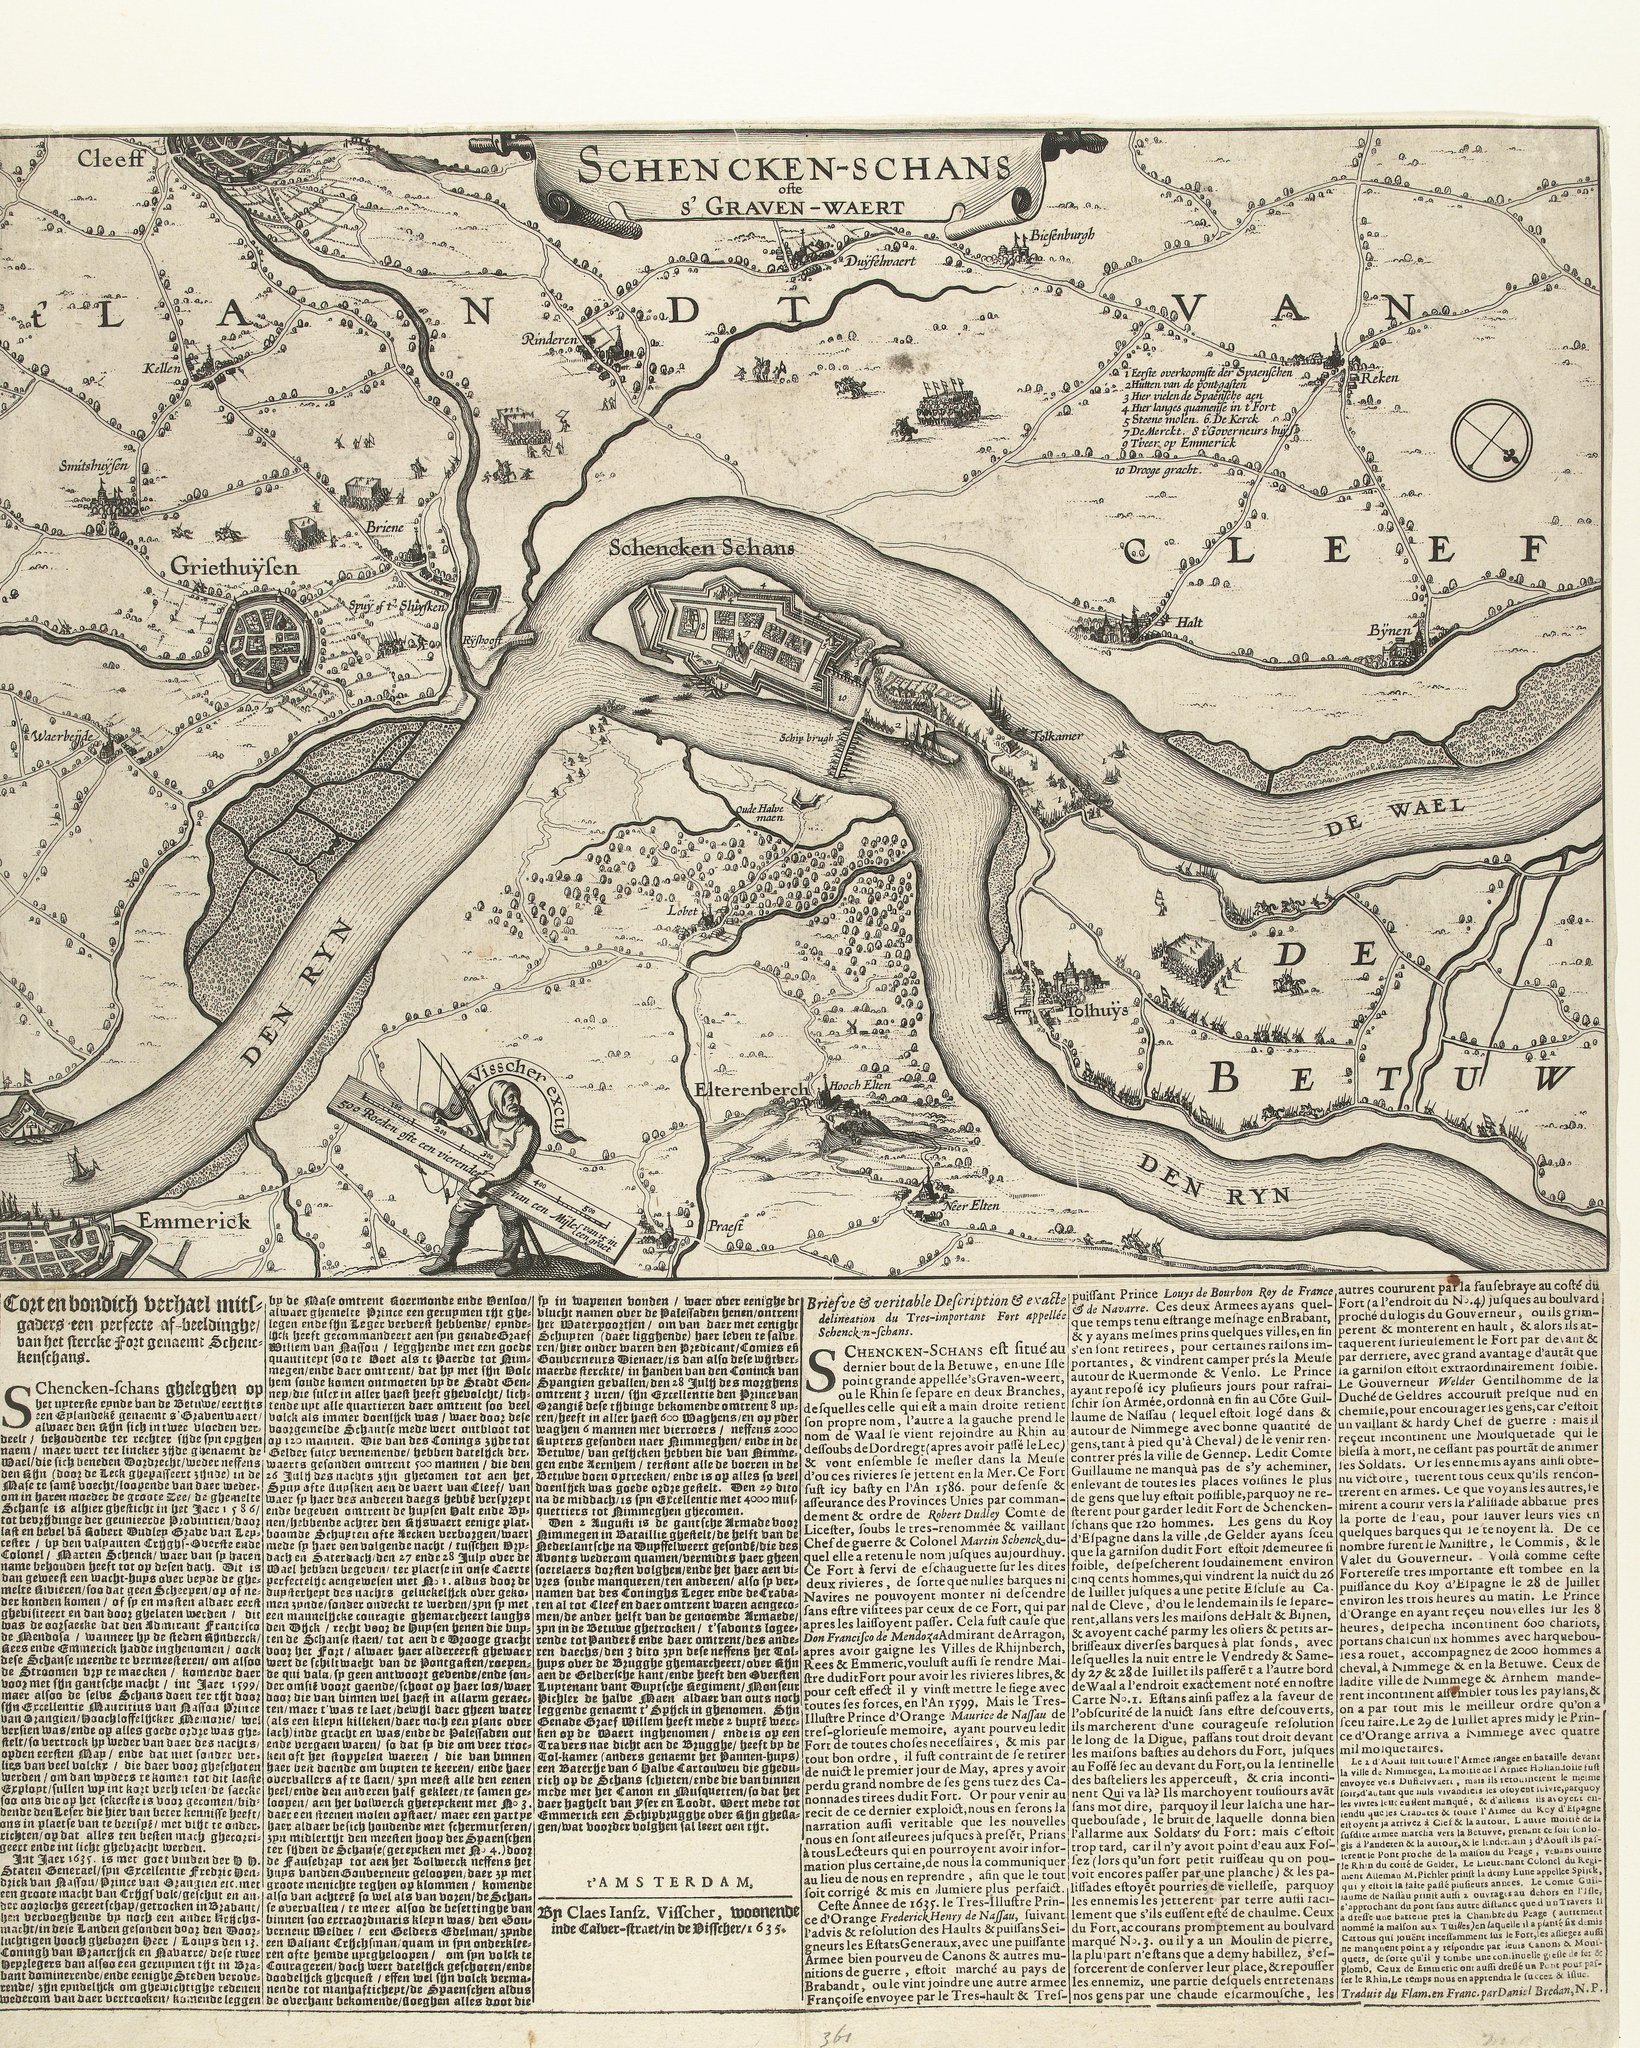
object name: print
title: Kaart van Schenckenschans belegerd door Frederik Hendrik, 1635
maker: claes jansz. visscher (ii)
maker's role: draughtsman, print maker, publisher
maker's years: 1586-1652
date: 1635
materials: paper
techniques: etching, letterpress printing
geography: amsterdam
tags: delft, frederick henry (prince of orange), maps of separate countries or regions, siege, position war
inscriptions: date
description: Kaart Schenckenschans en het rivierengebied belegerd door het Staatse leger onder Frederik Hendrik, augustus 1635. Onder plaat is een tekstblad geplakt met een beschrijving van de gebeurtenissen in 3 kolommen in het Nederlands en 3 kolommen in het Frans. Rechtsboven in de voorstelling de legenda 1-10, linksonder een staand vissertje met de schaalaanduiding.